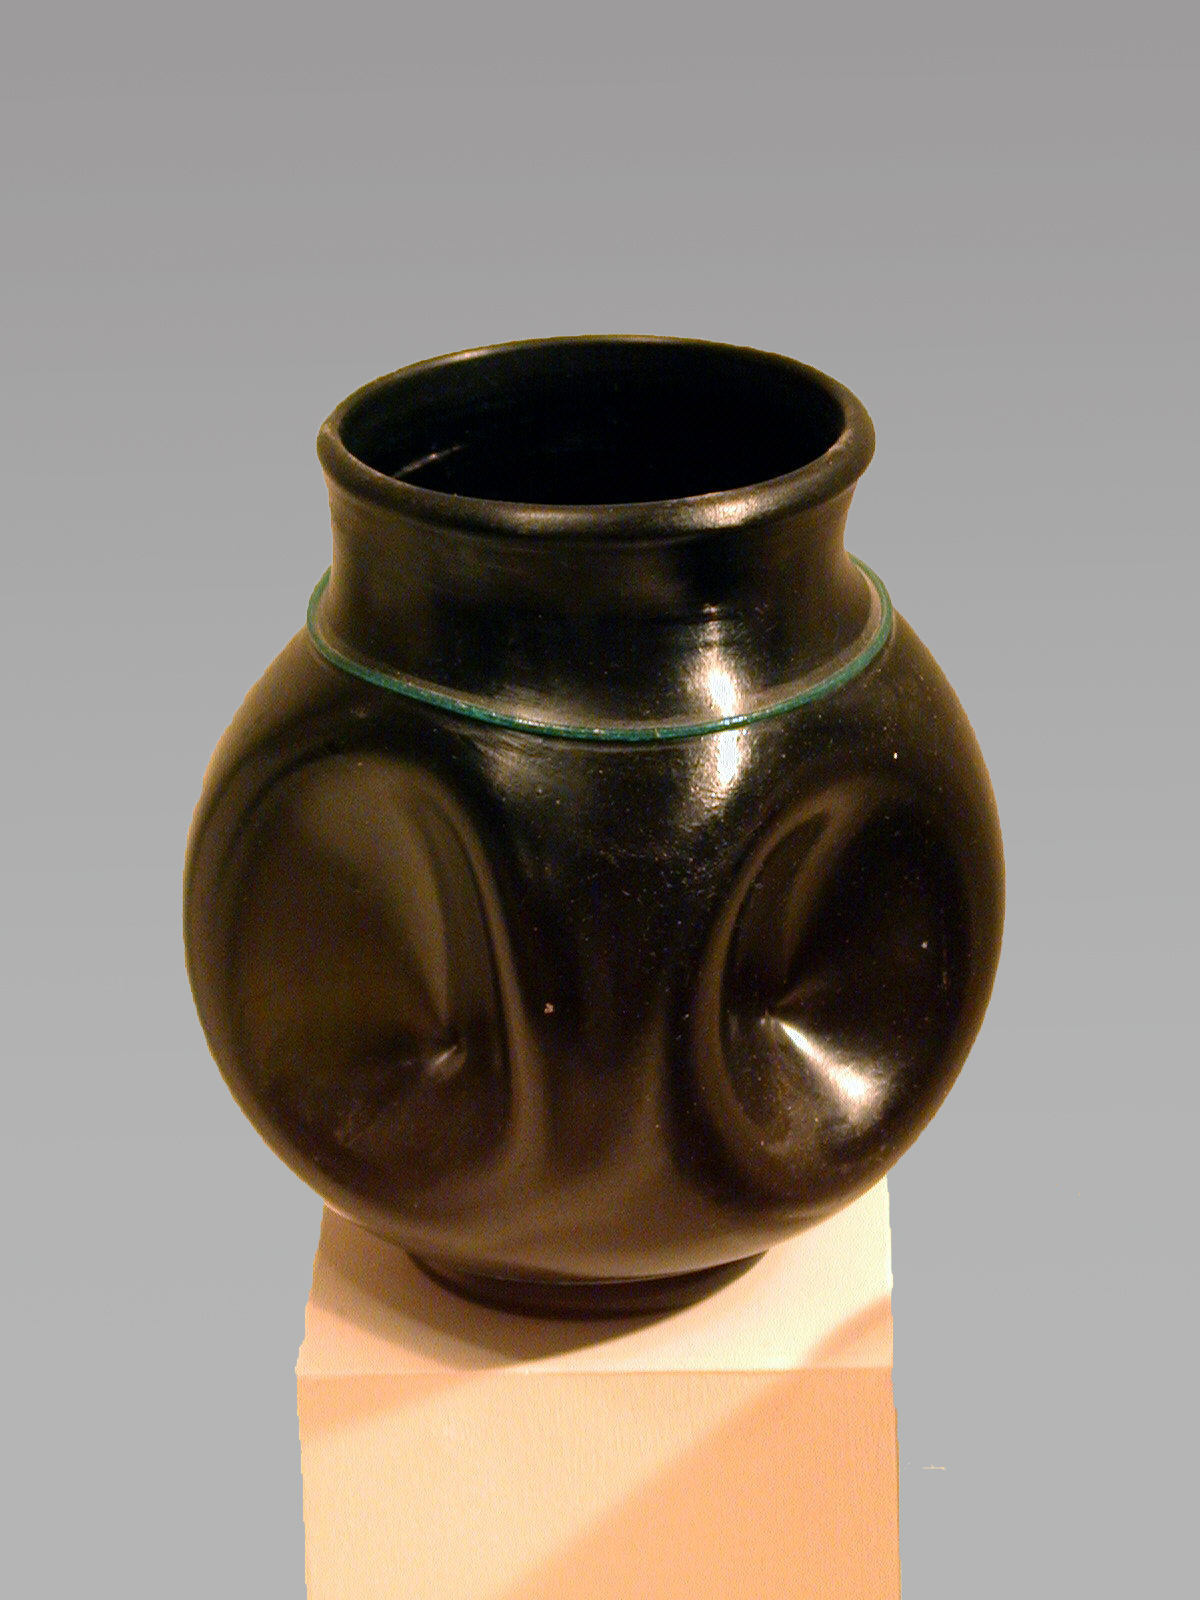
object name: beaker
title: Glass beaker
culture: roman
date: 167-266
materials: glass